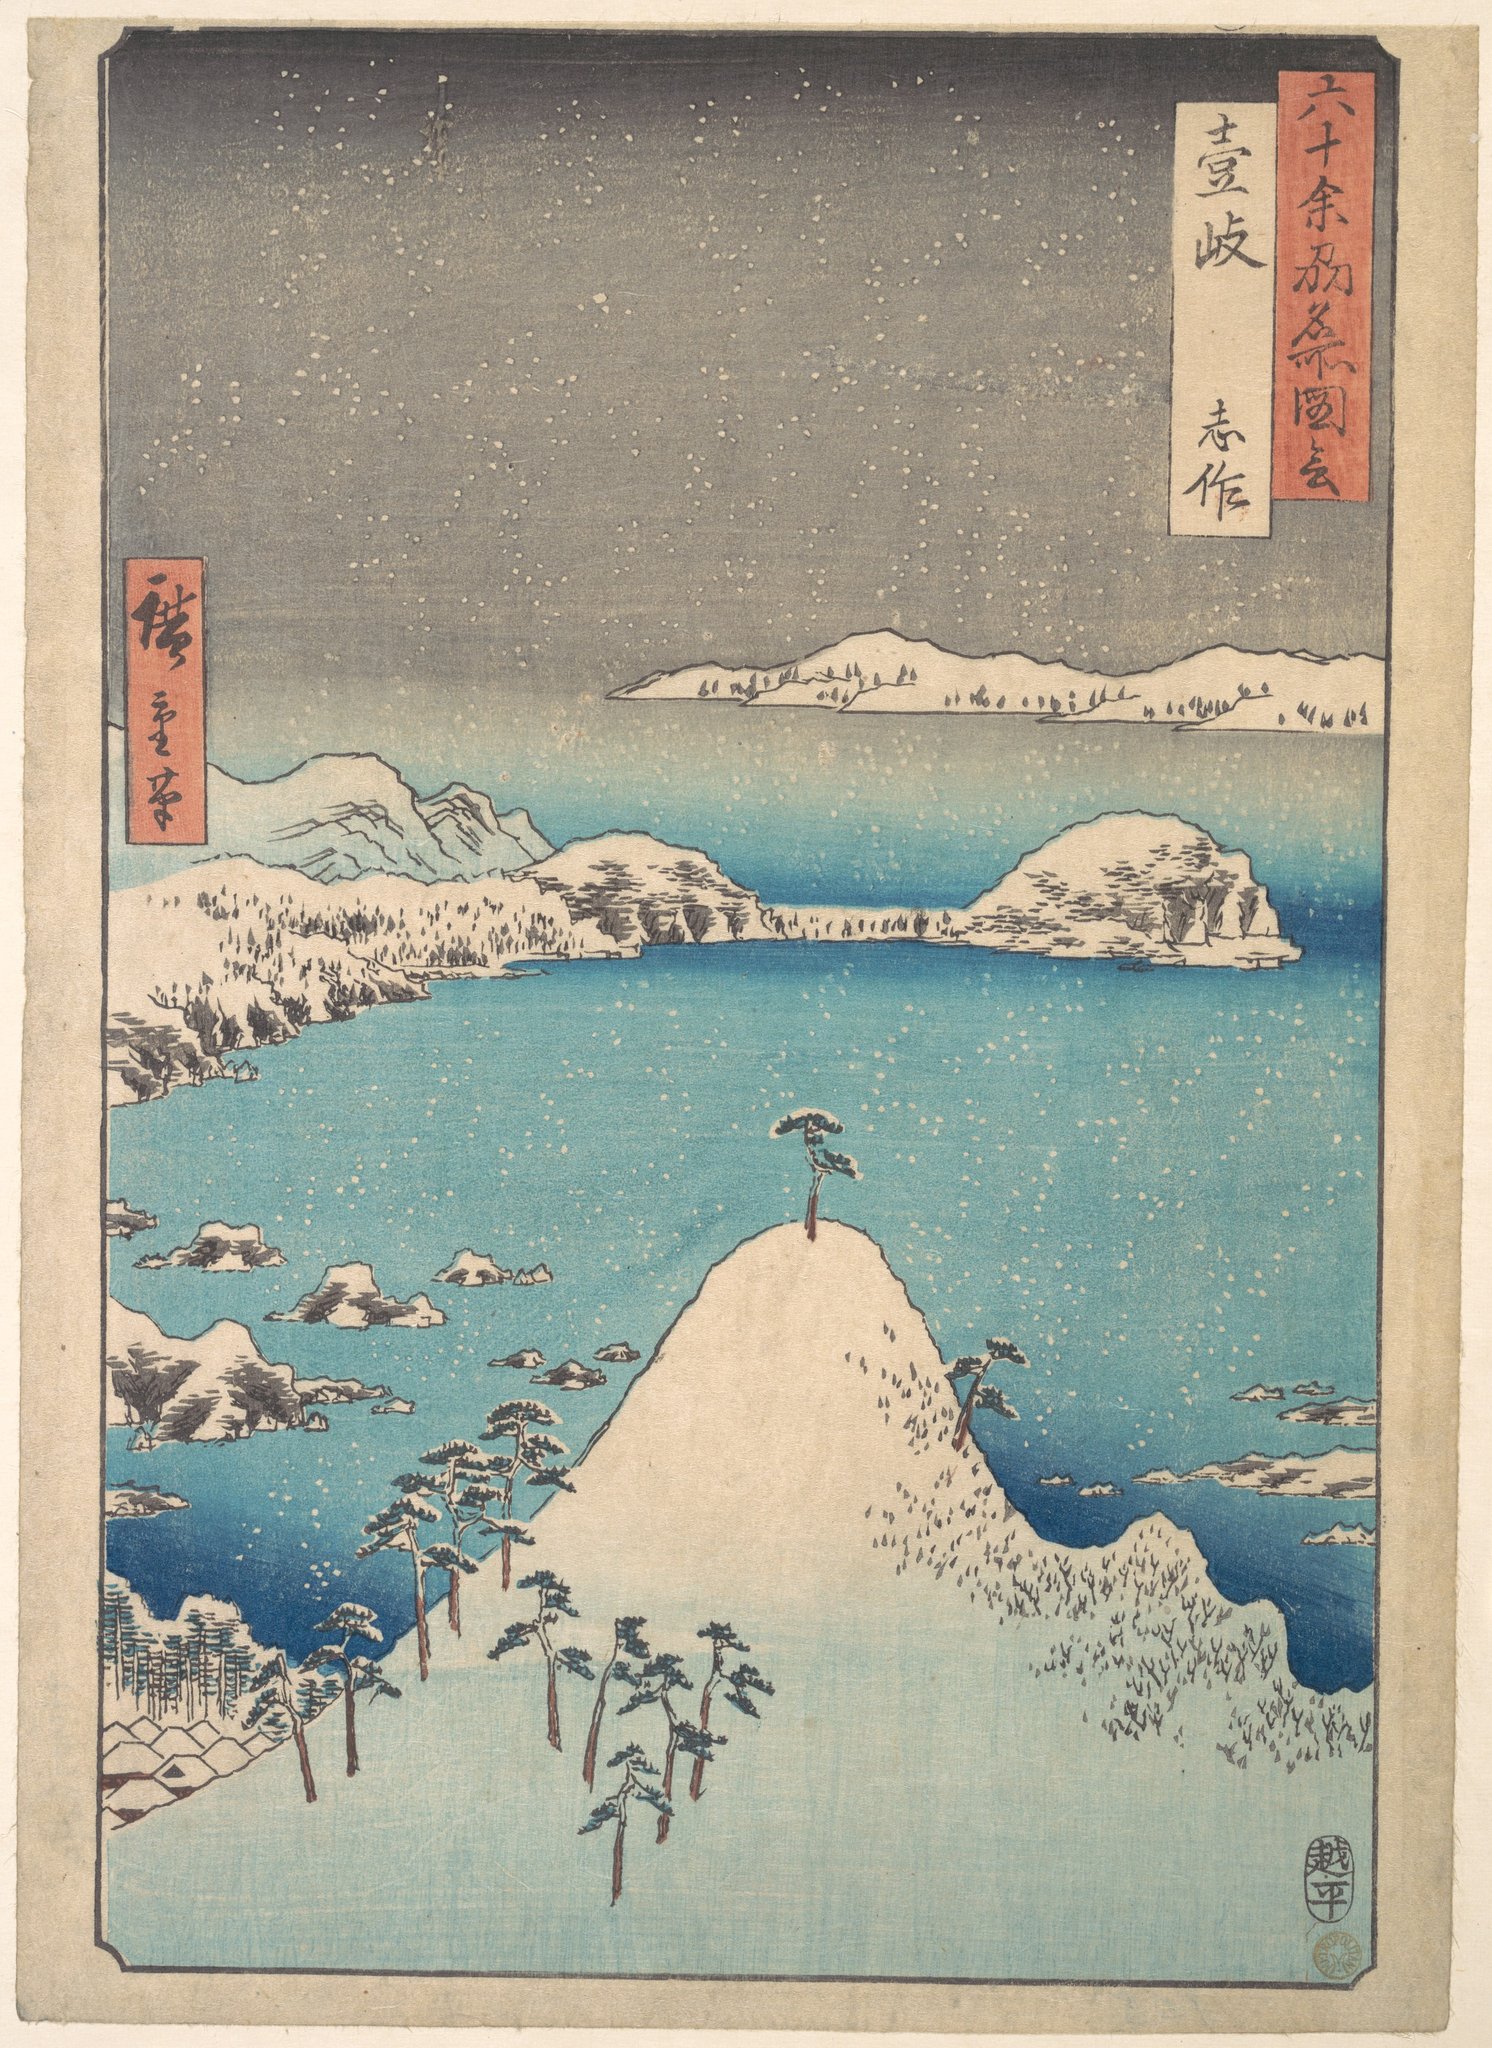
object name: print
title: Winter View of Shimasaku in the Province of Iki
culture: japanese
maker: utagawa hiroshige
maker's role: artist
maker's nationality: japanese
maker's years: 1797-1858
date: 1856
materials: ink, paper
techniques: woodblock print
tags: landscapes,winter,snow